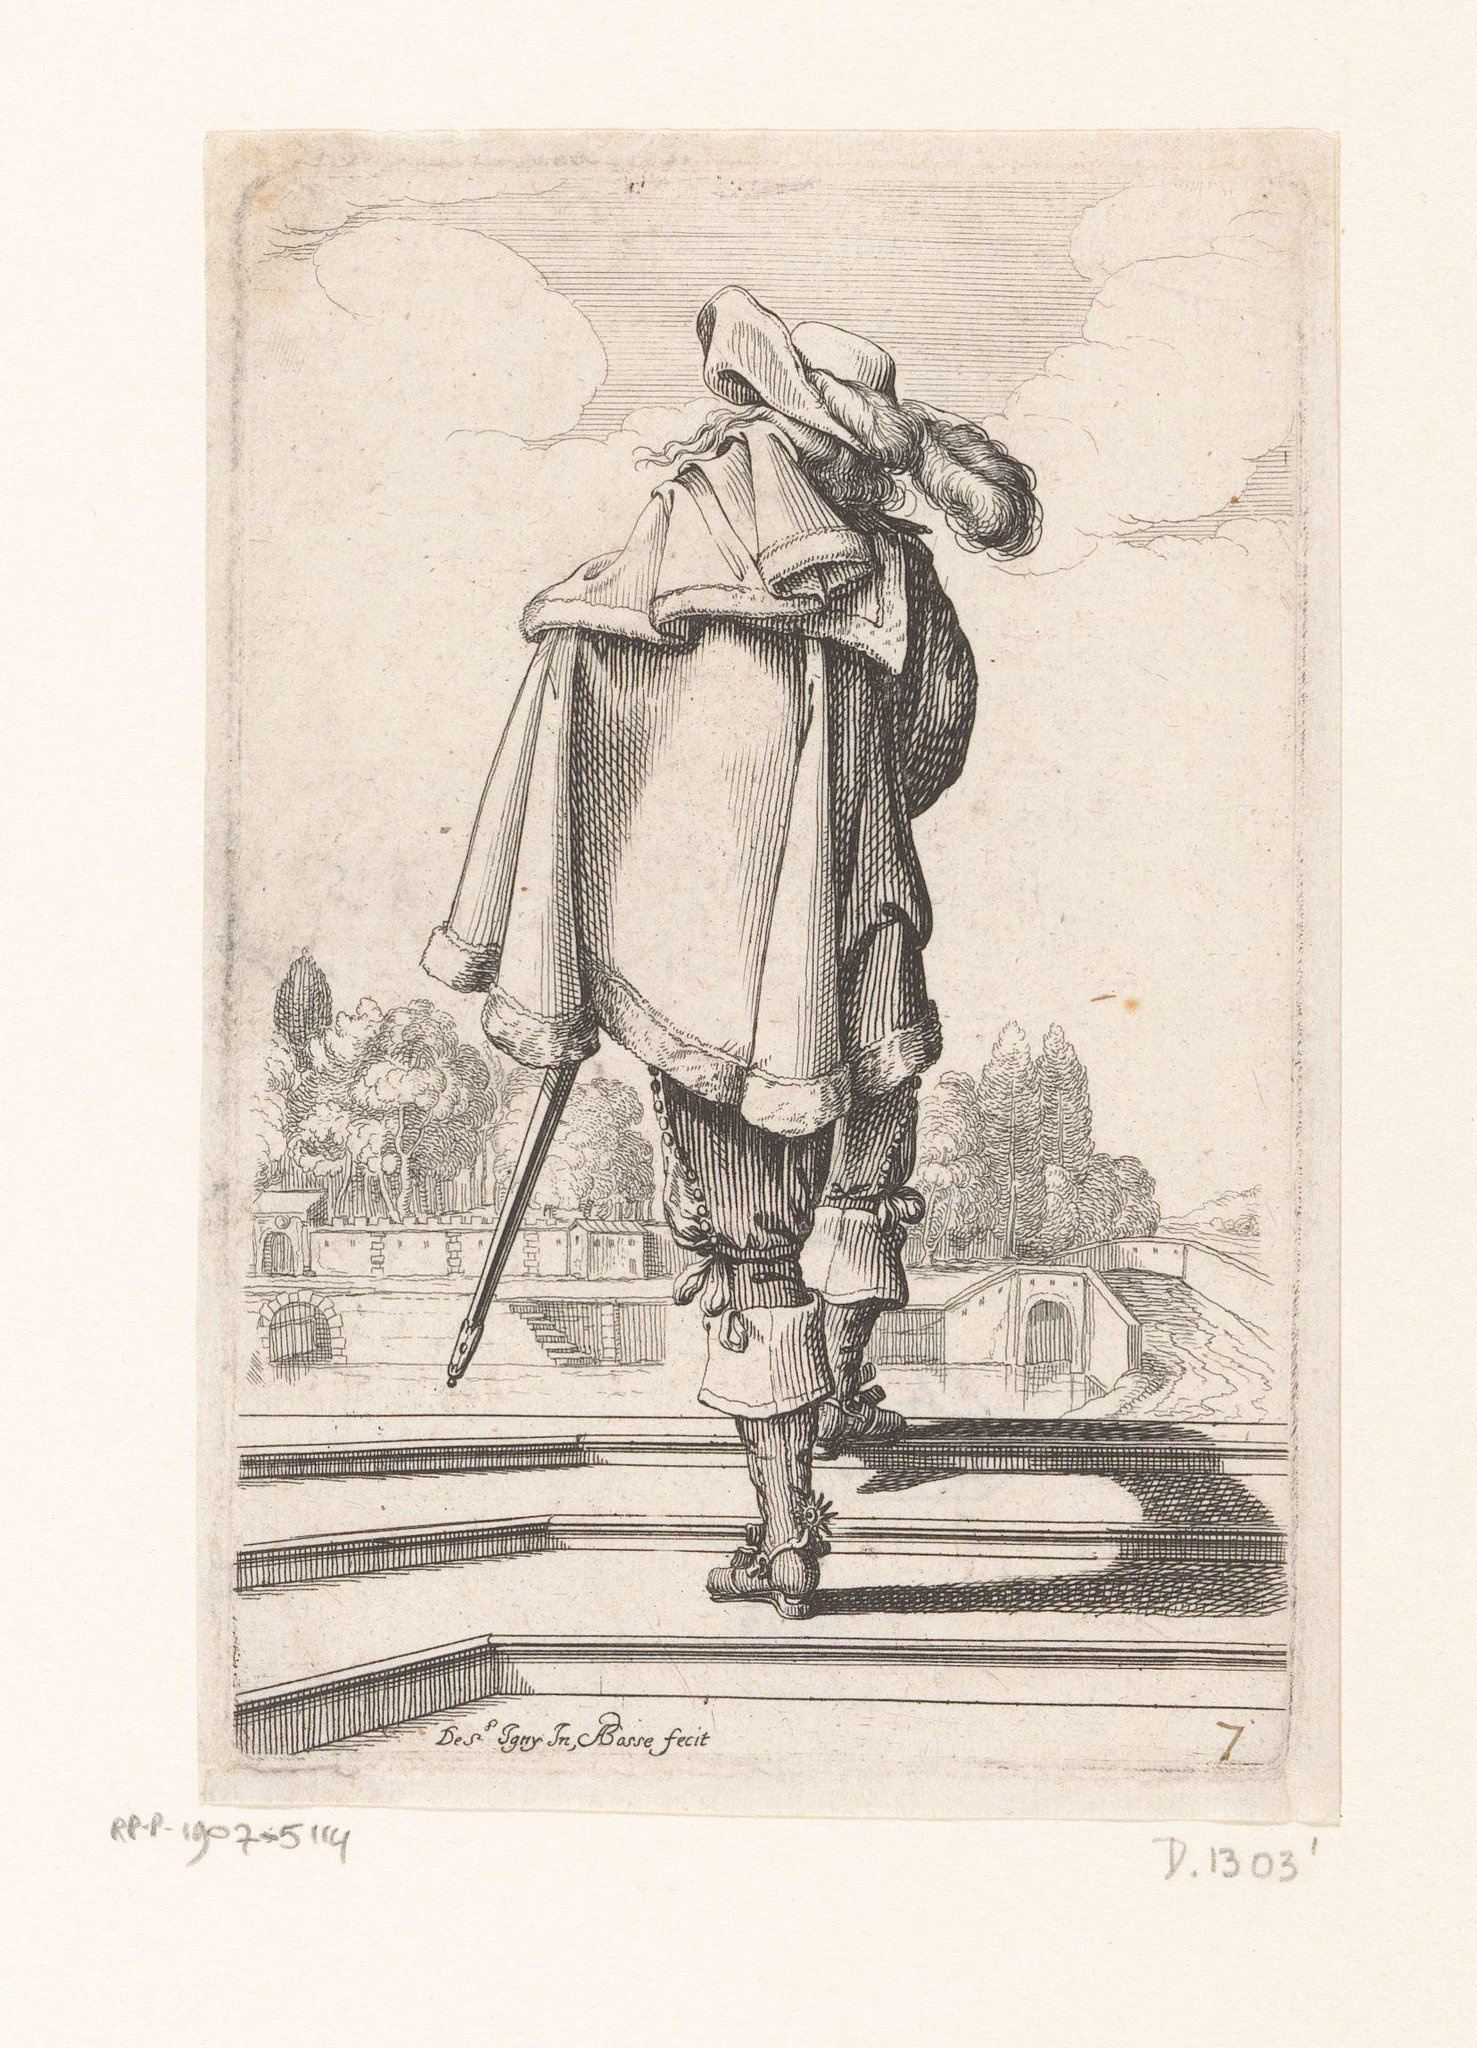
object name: costume print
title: Franse edelman op de rug gezien, gekleed volgens de mode van ca. 1630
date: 1629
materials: paper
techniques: engraving, etching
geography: paris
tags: cape (+ men's clothes), head-gear: hat (+ men's clothes), europeans (with name), clothes, costume (+ men's clothes), shoes, sandals, trousers, breeches, etc. (breeches) (+ men's clothes), hacking and thrusting weapons (foil), boots (+ men's clothes), head-gear: hat (+ feathers used for clothes)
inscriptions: number: ‘7’, collector's mark: Lugt 2228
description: Maakt deel uit van een serie met twintig kostuumprenten van Franse edellieden naar ontwerp van Abraham Bosse en Jean de Saint-Igny, in 1629 uitgegeven door Melchior Tavernier en een tweede staat door François Langlois.